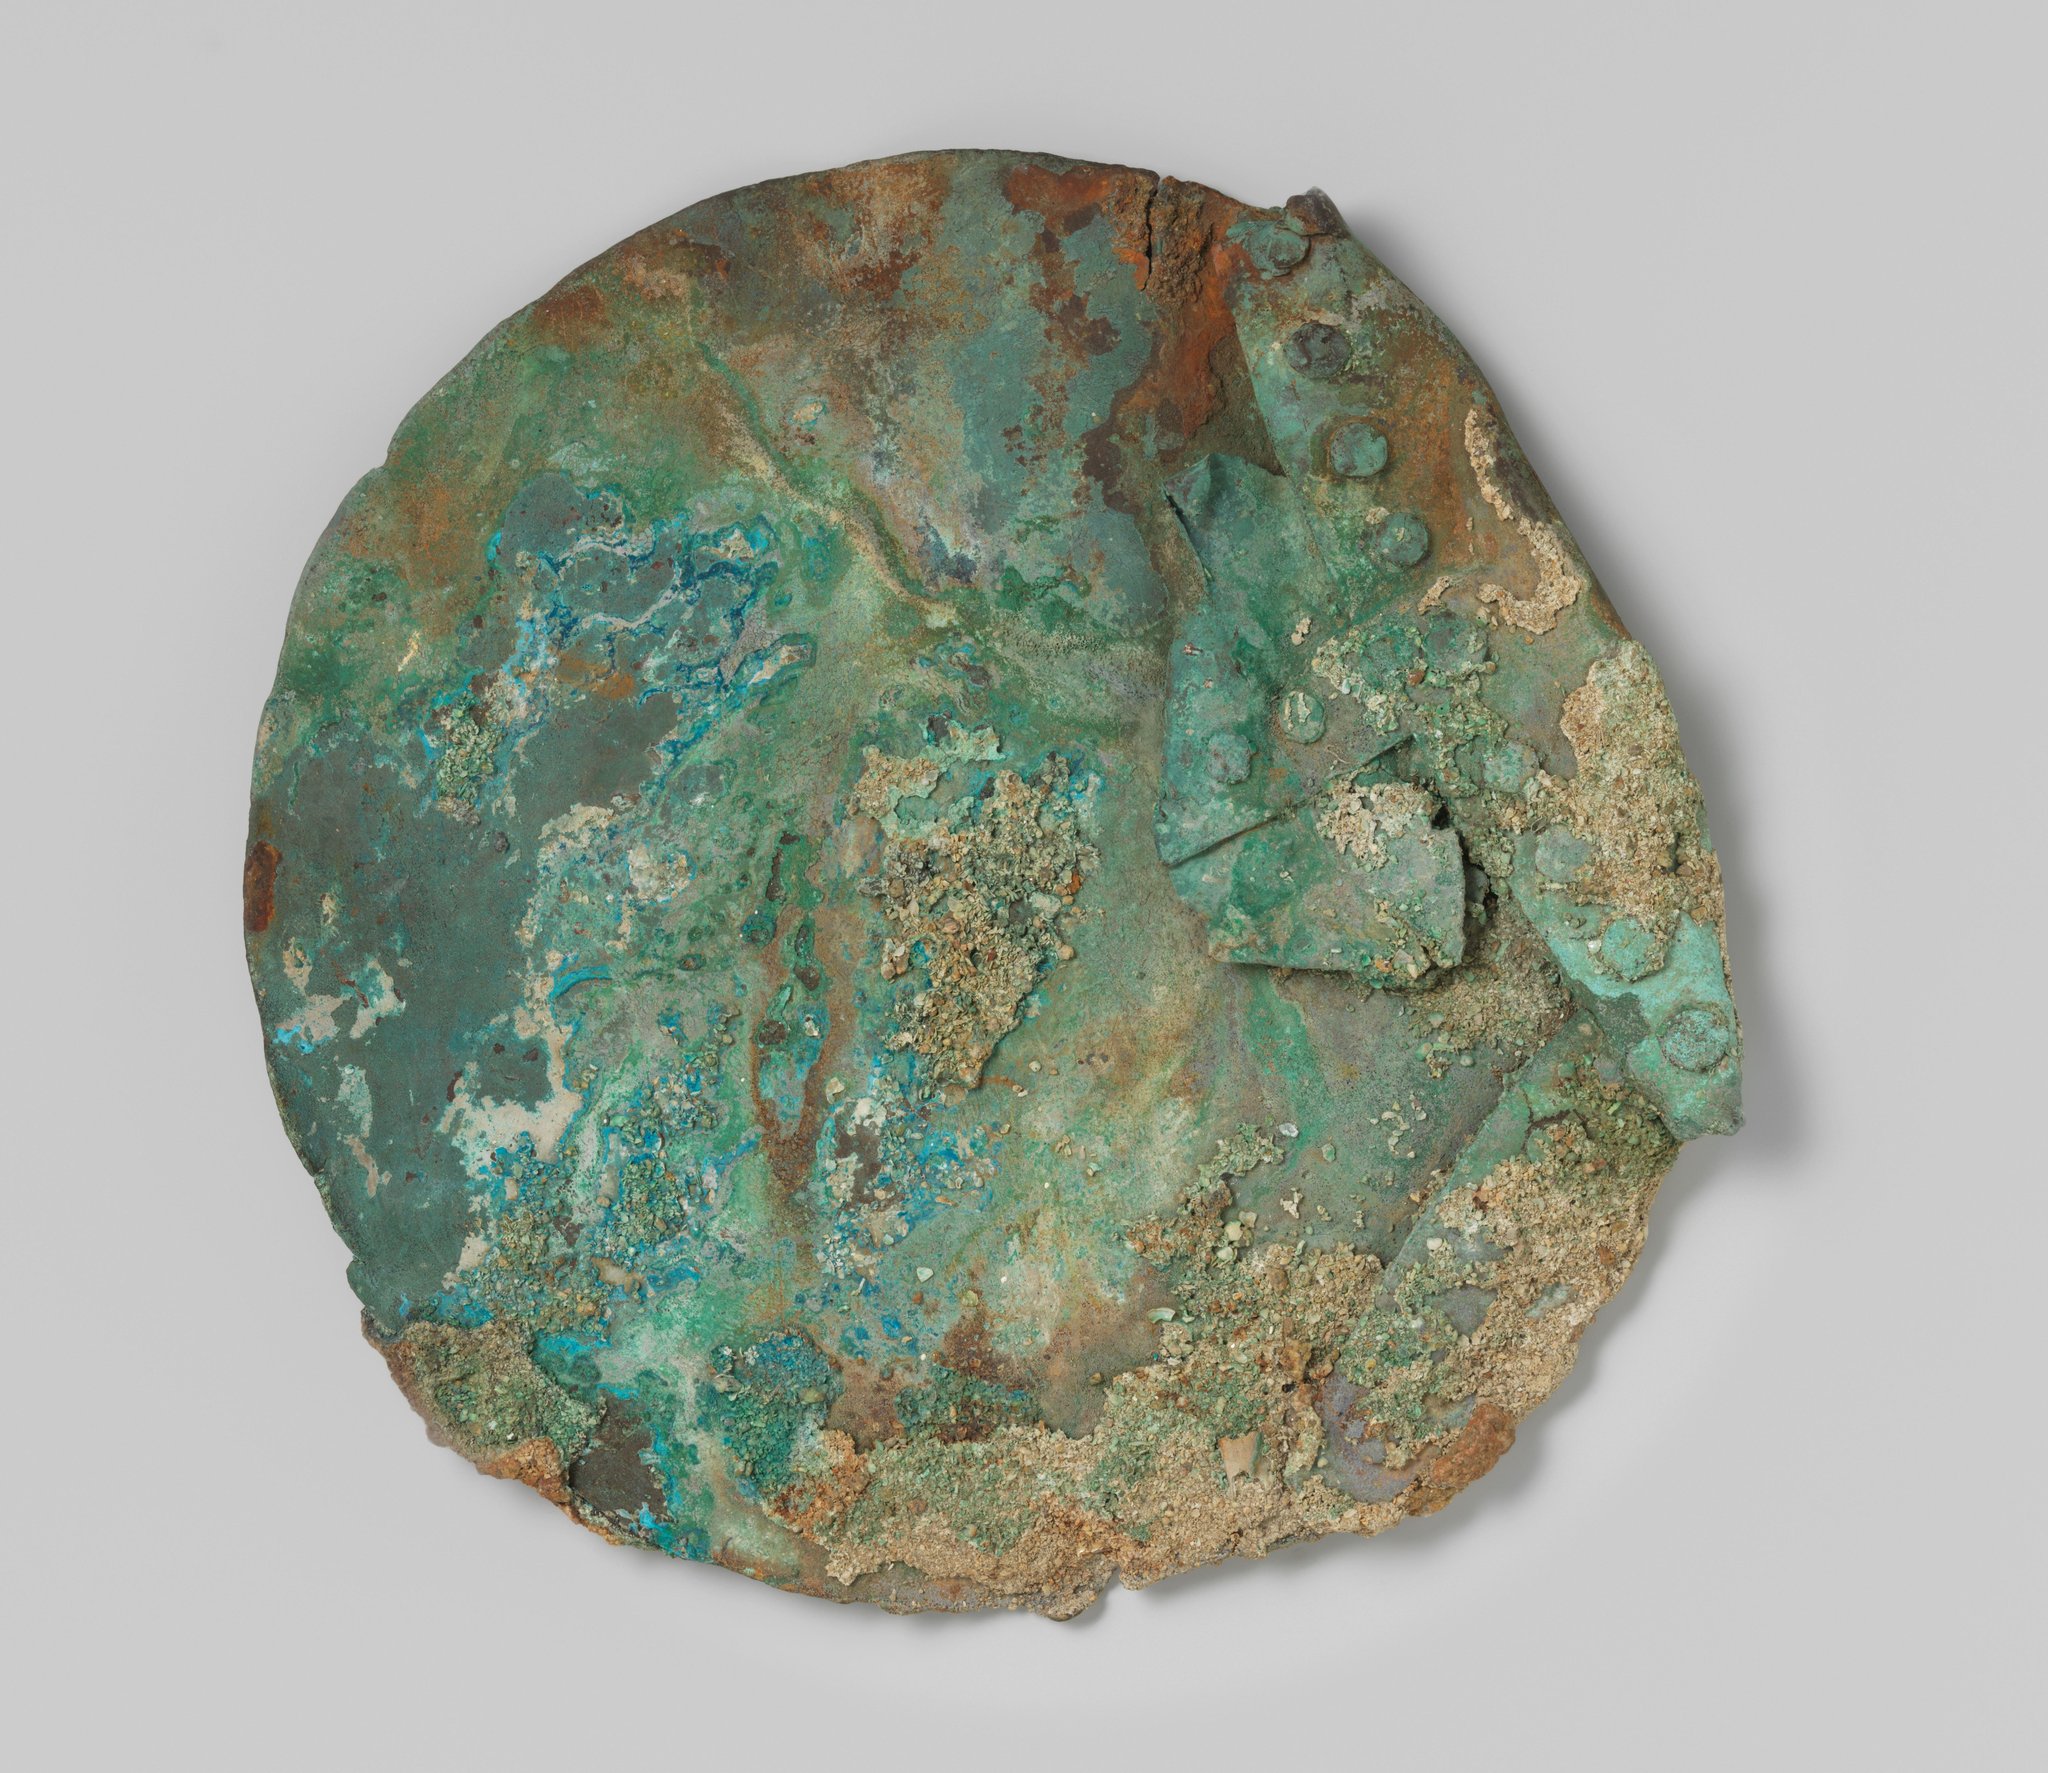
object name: cauldron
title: Bodem van een kookpot uit het wrak van de Oost-Indiëvaarder Hollandia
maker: Anonymous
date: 1700-1743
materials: copper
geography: netherlands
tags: verenigde oostindische compagnie, hollandia (schip), annet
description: Suspension cauldron, bottem; circular, with fragm of riveted sides, squashed.